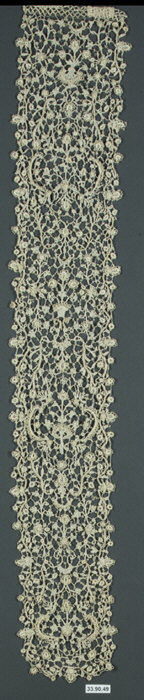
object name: lappet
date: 1601-1700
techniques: lace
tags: flowers